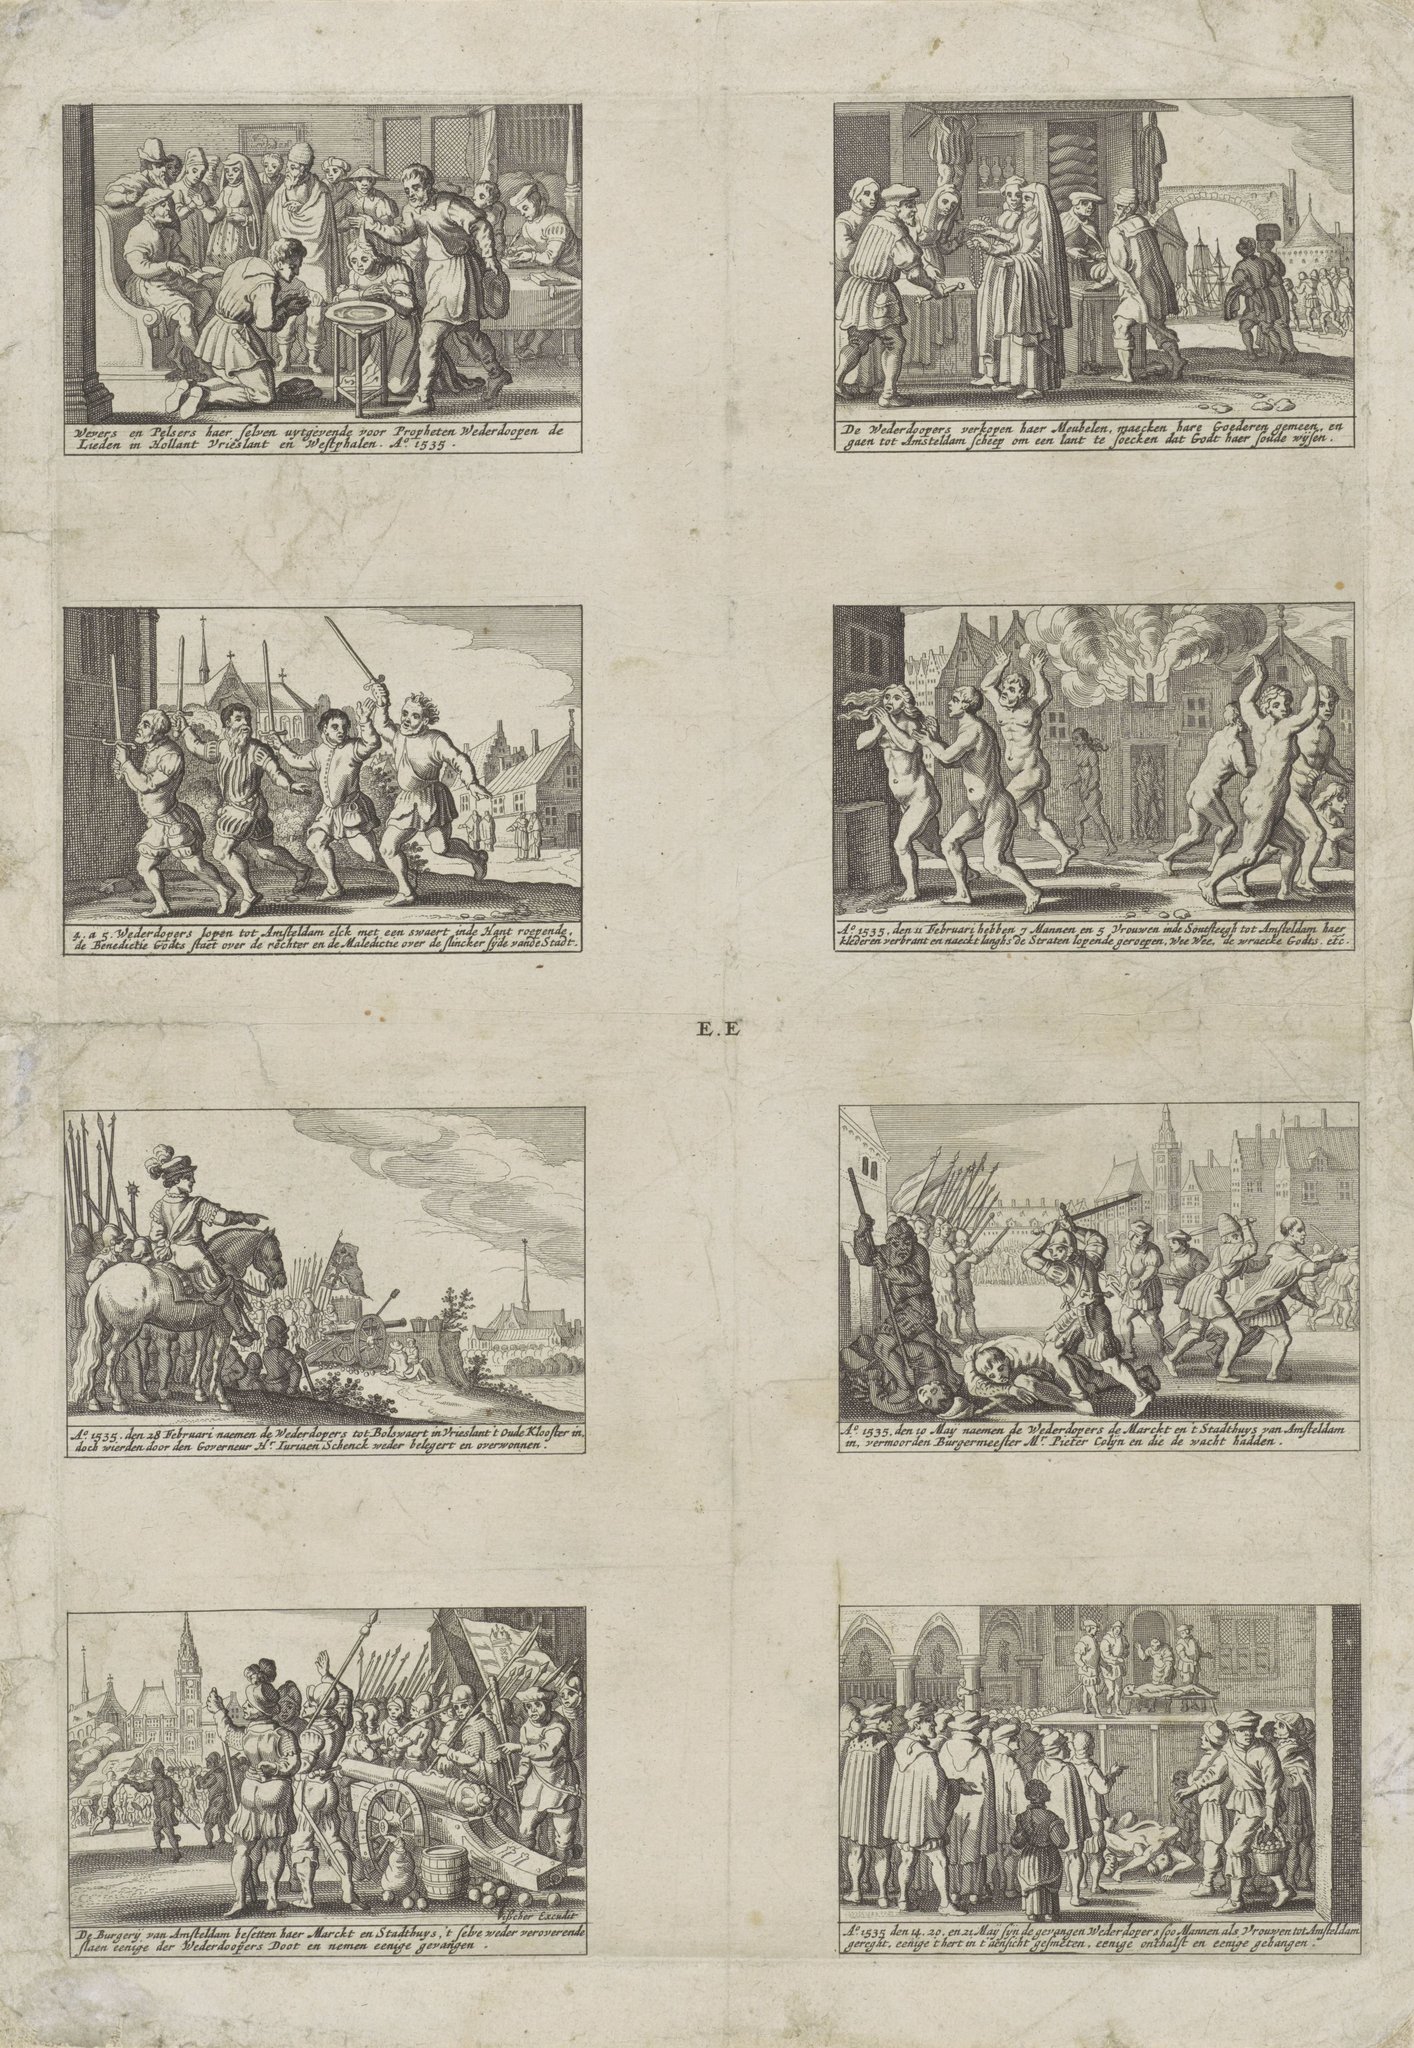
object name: print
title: Wederdopersoproer in Amsterdam en Friesland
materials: paper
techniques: etching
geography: netherlands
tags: battle, woman (showing herself) undressed, quasi-nude, attack ~ siege, man (showing himself) undressed, quasi-nude, amsterdam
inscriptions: collector's mark: Lugt 2760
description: Blad met 8 voorstellingen van de wederdopersoproer in Amsterdam en Friesland. Onder elke afbeelding een onderschrift. Gemerkt midden: E.E.